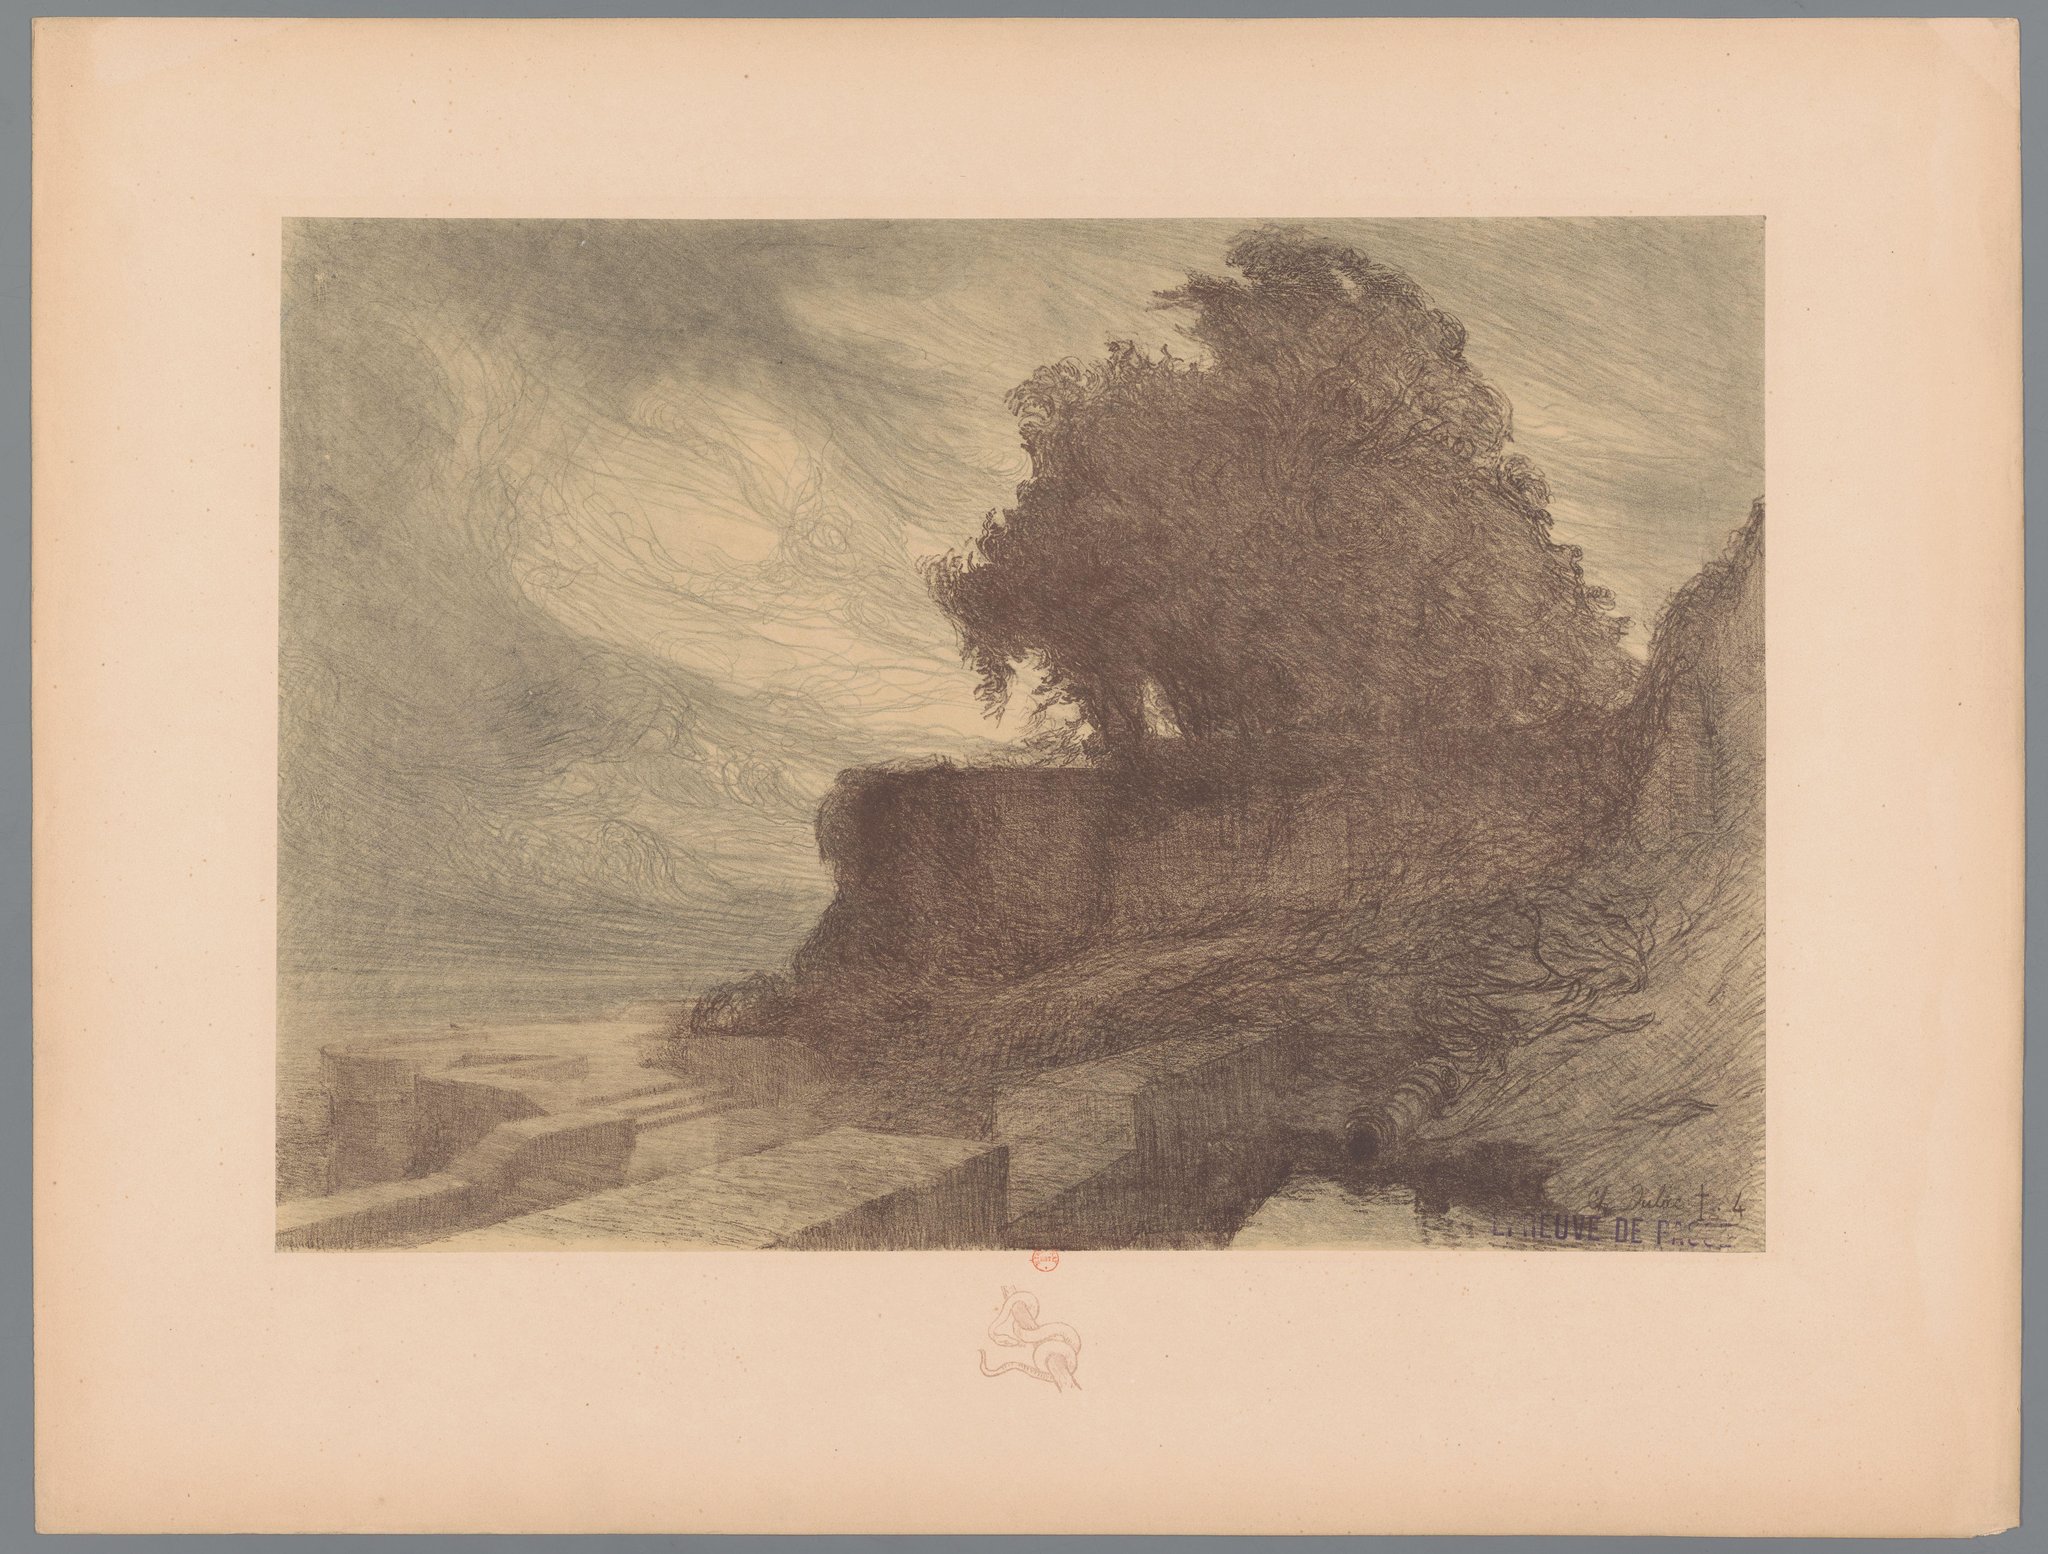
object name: print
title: Landschappen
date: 1892-1893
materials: paper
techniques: lithography, lithograph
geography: paris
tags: ruin of a building ~ architecture, bastion, bulwark, firearms: cannon, ruin of a dwelling, house, castle, etc.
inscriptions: stamp: ‘Épreuve de passe’, collector's mark: Lugt 2228a, stamp: ‘B.N. éch. 1976’, collector's mark: Lugt 2760, collector's mark: Lugt 249